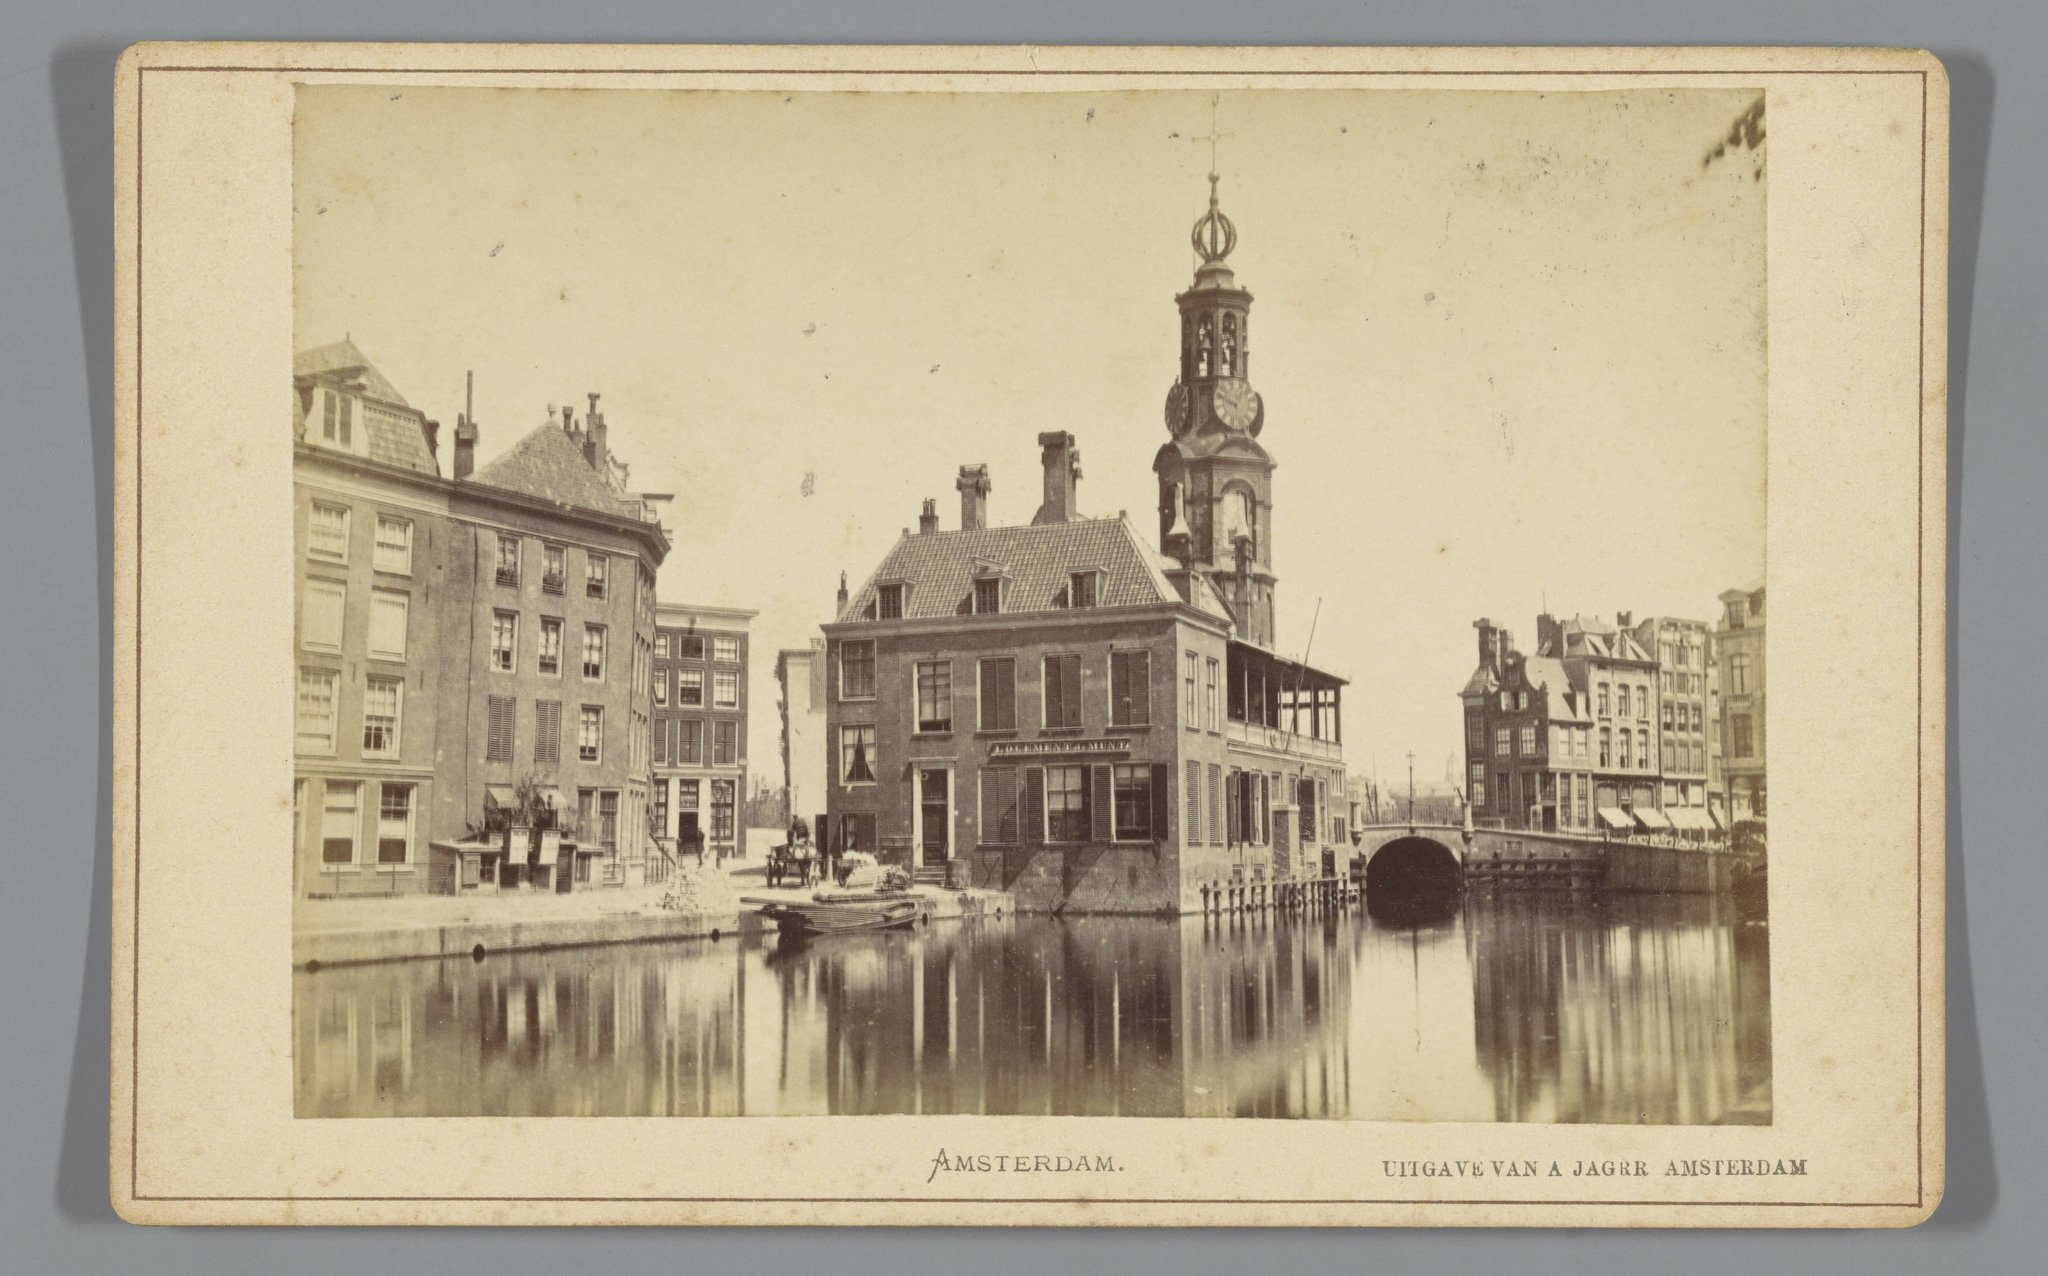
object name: cabinet photograph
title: Amsterdam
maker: andries jager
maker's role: publisher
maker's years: 1825-1905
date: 1860-1890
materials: cardboard, photographic support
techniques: albumen print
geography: amsterdam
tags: canals, waters (in city), hotel, hostelry, inn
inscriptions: annotation: ‘Hôtel de Munt, en Schapenplein/ thans Sophiaplein’